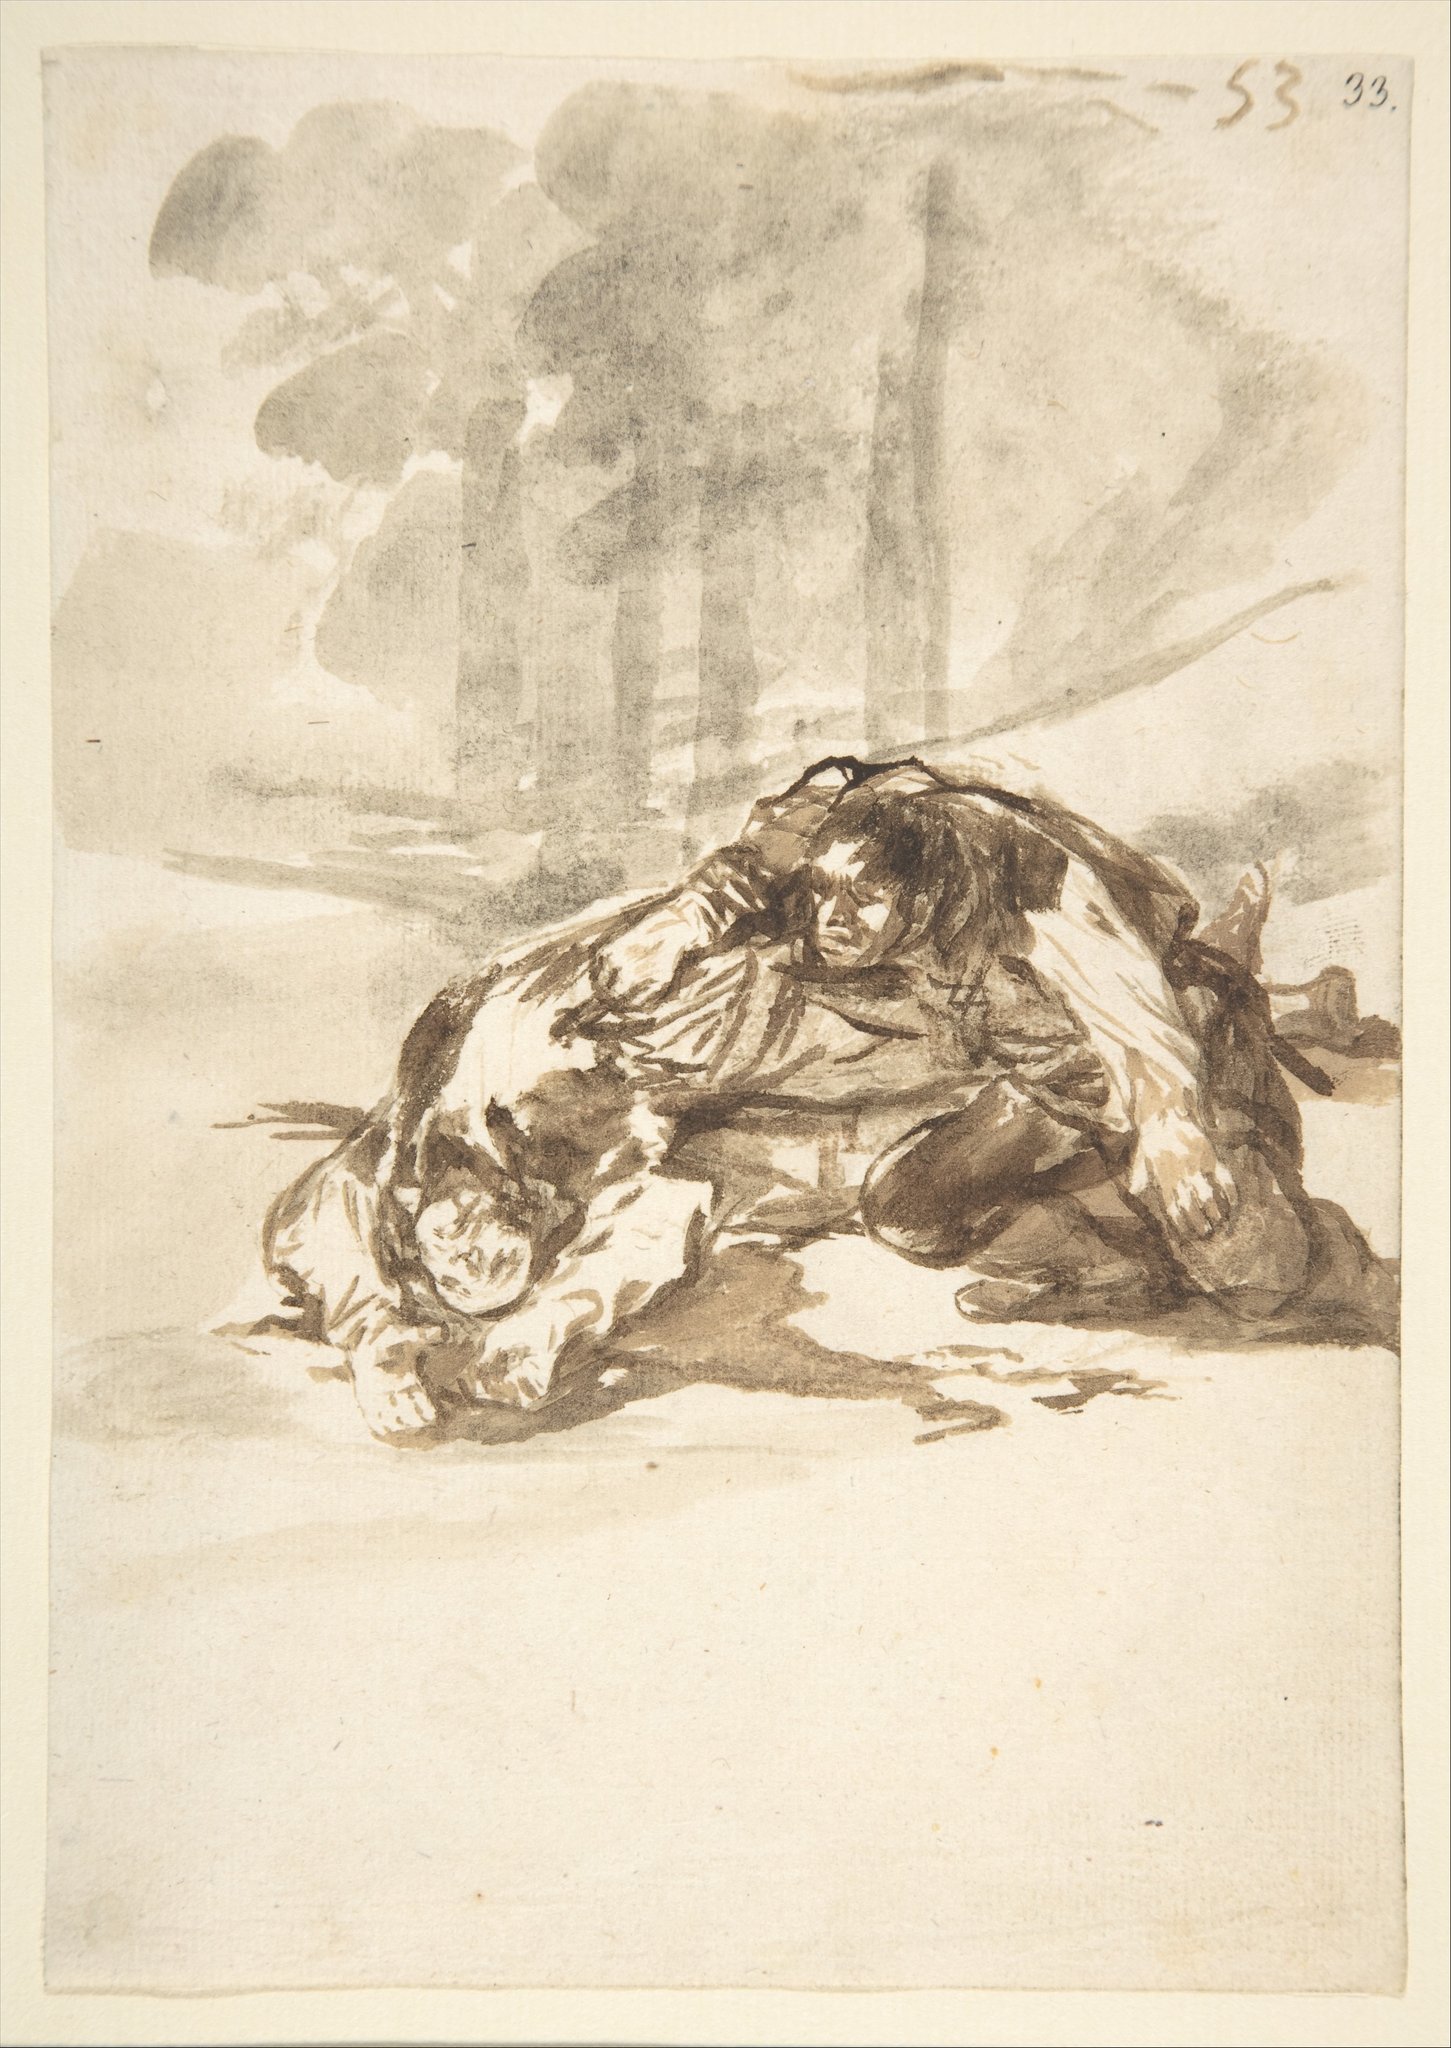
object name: drawing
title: A man stabbing another; folio 53 from the "Images of Spain" Album (F)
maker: goya (francisco de goya y lucientes)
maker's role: artist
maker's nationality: spanish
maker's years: 1746-1828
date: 1812-1820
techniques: brush, wash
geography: spain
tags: men